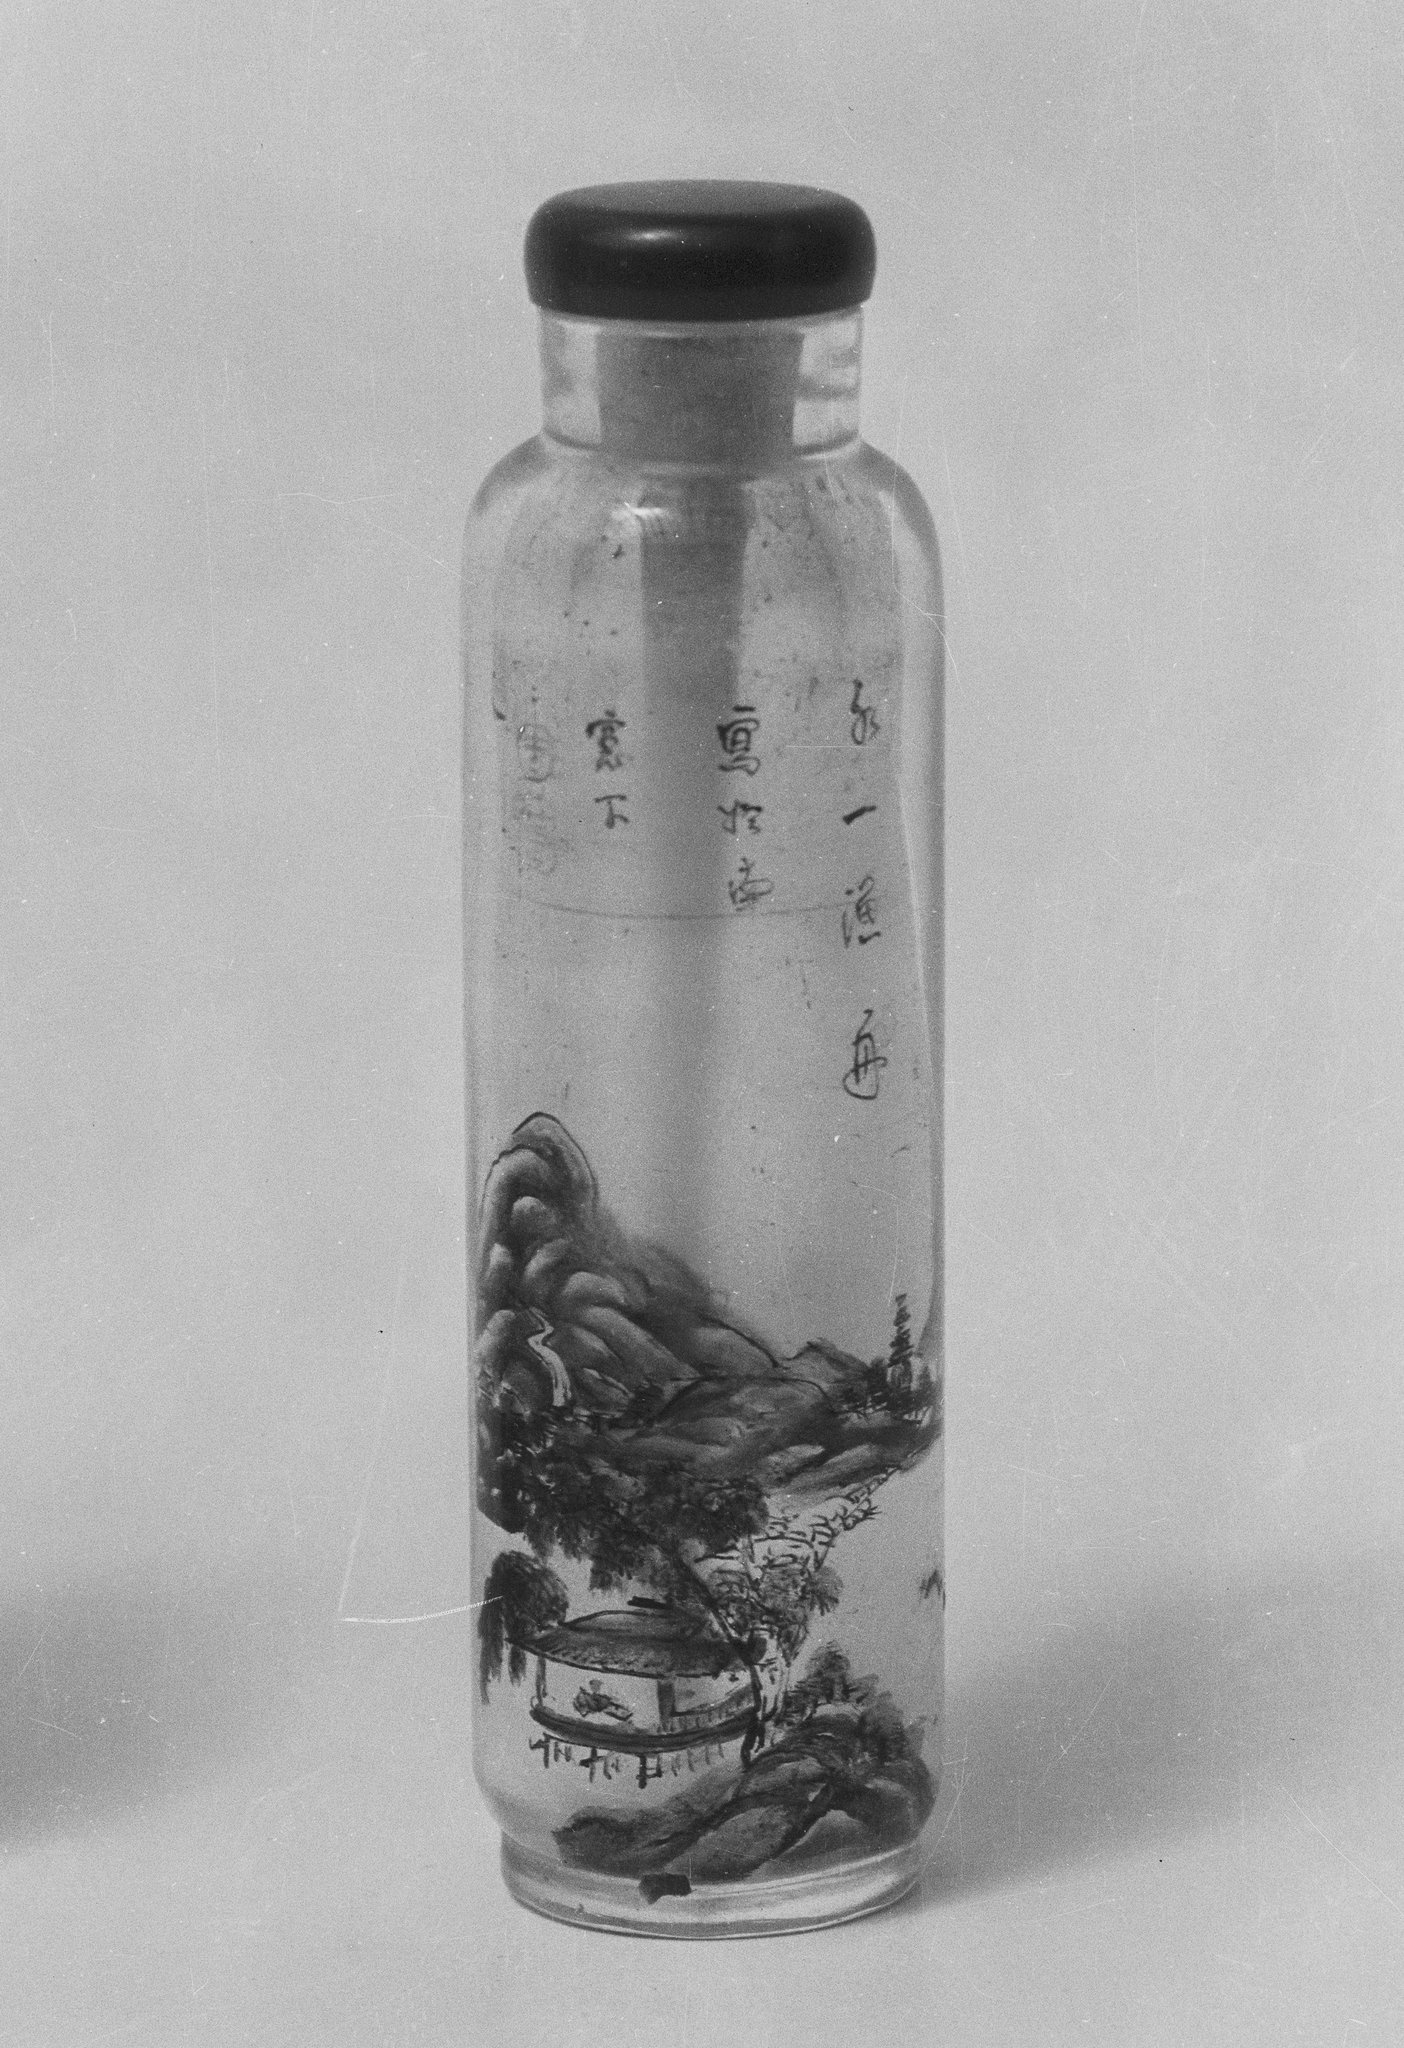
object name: snuff bottle with stopper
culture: chinese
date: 1701-1900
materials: bone, quartz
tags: landscapes